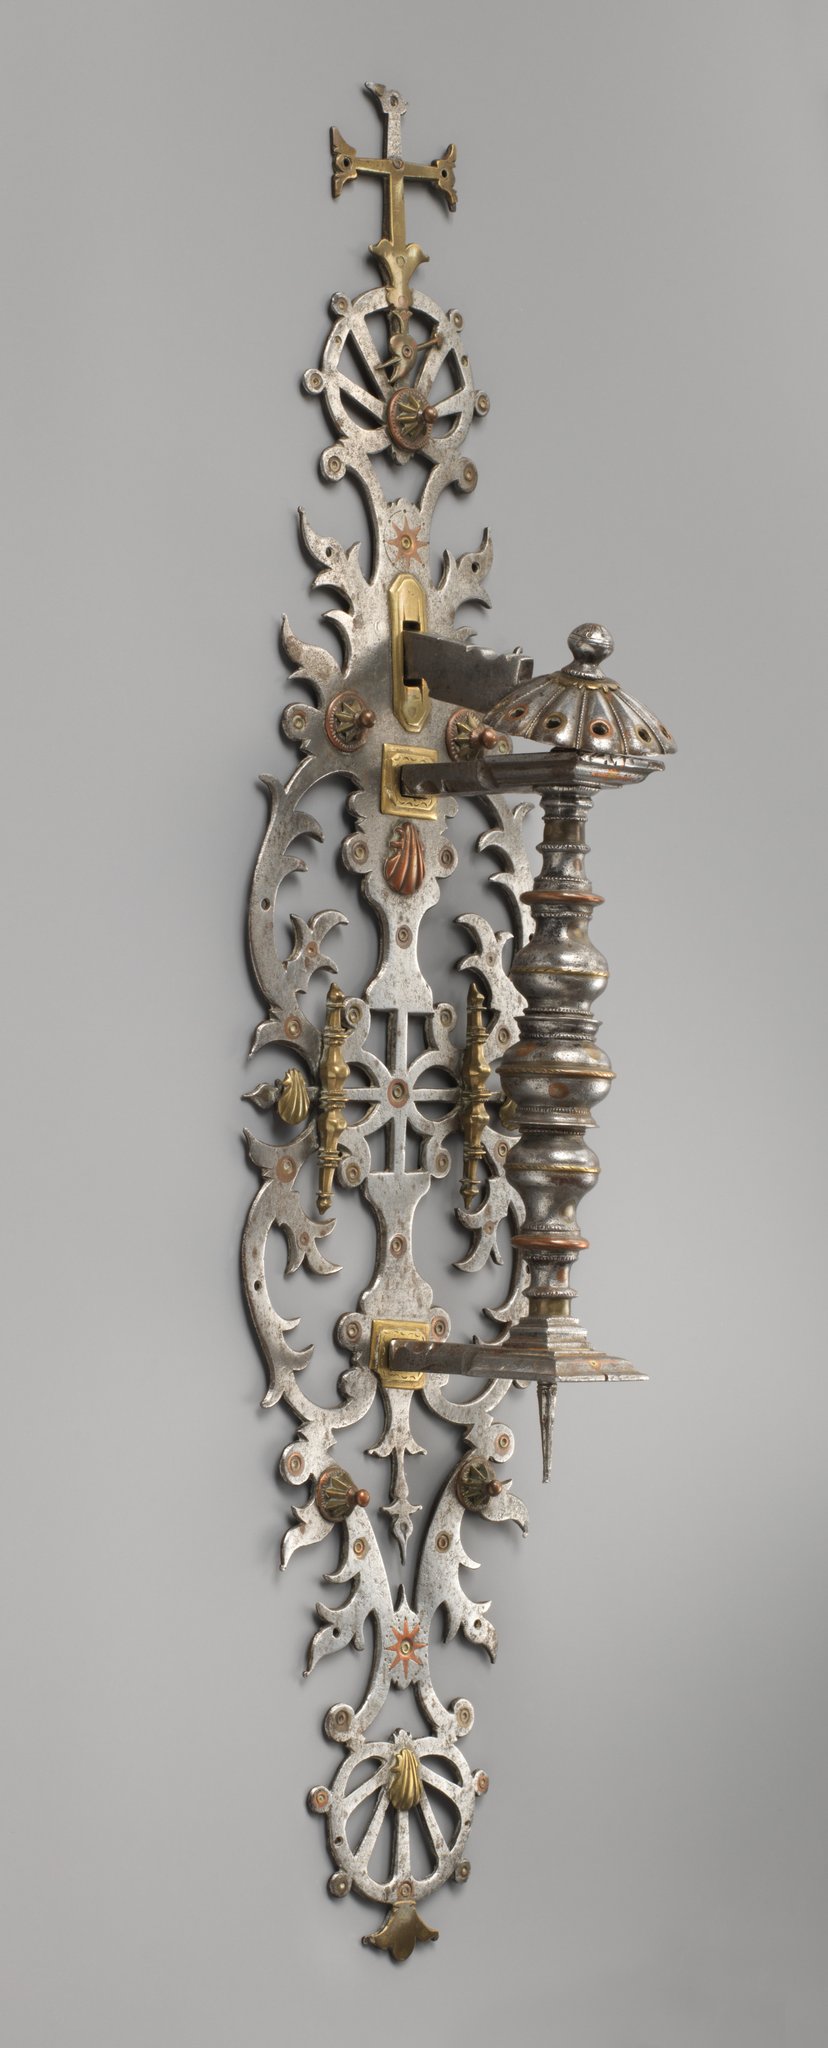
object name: handle and escutcheon with latch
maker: Anonymous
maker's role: maker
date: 1701-1800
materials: brass, copper, iron